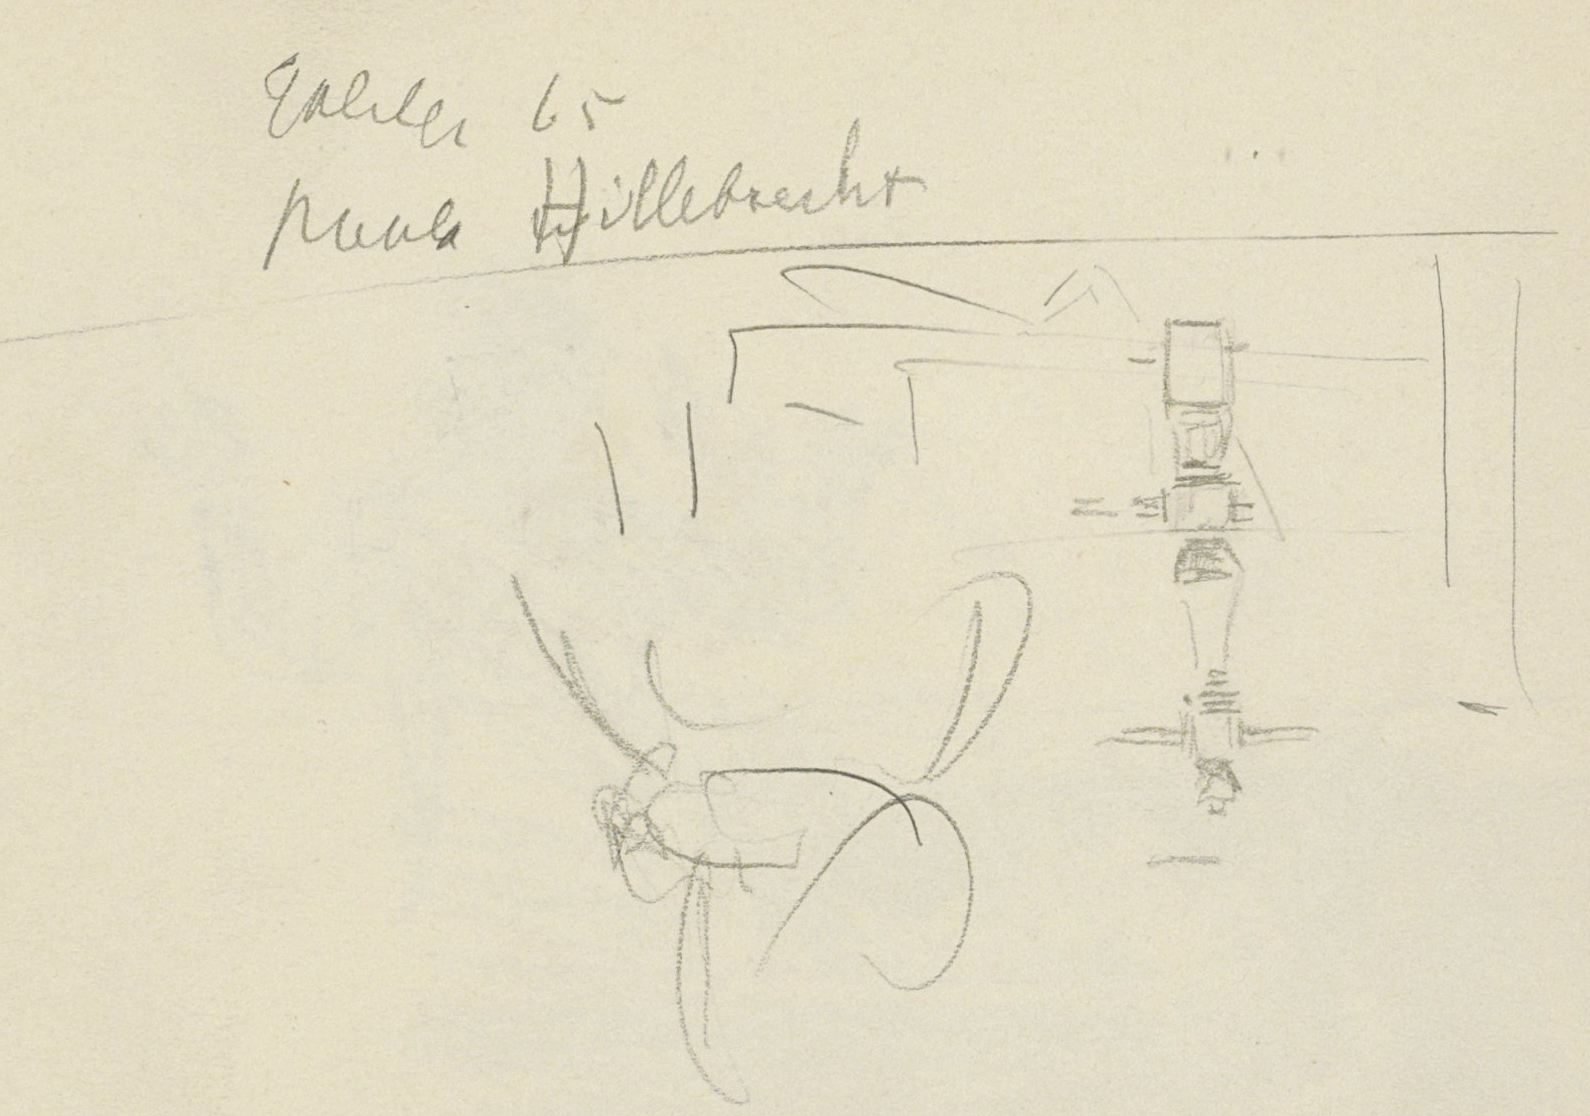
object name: sketchbook leaf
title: Studies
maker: isaac israels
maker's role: draughtsman, painter, print maker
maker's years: 1865-1934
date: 1930-1934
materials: paper, pencil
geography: the hague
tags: theatre, theatrical performance, the (nude) human figure; 'corpo humano' (ripa)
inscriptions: annotation: ‘Galilei 65 / paal[?] Hillebrecht’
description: Mogelijk een compositiestudie van een theatervoorstelling en een figuurstudie. Pagina 40 uit schetsboek XXXVIII met 45 pagina's.